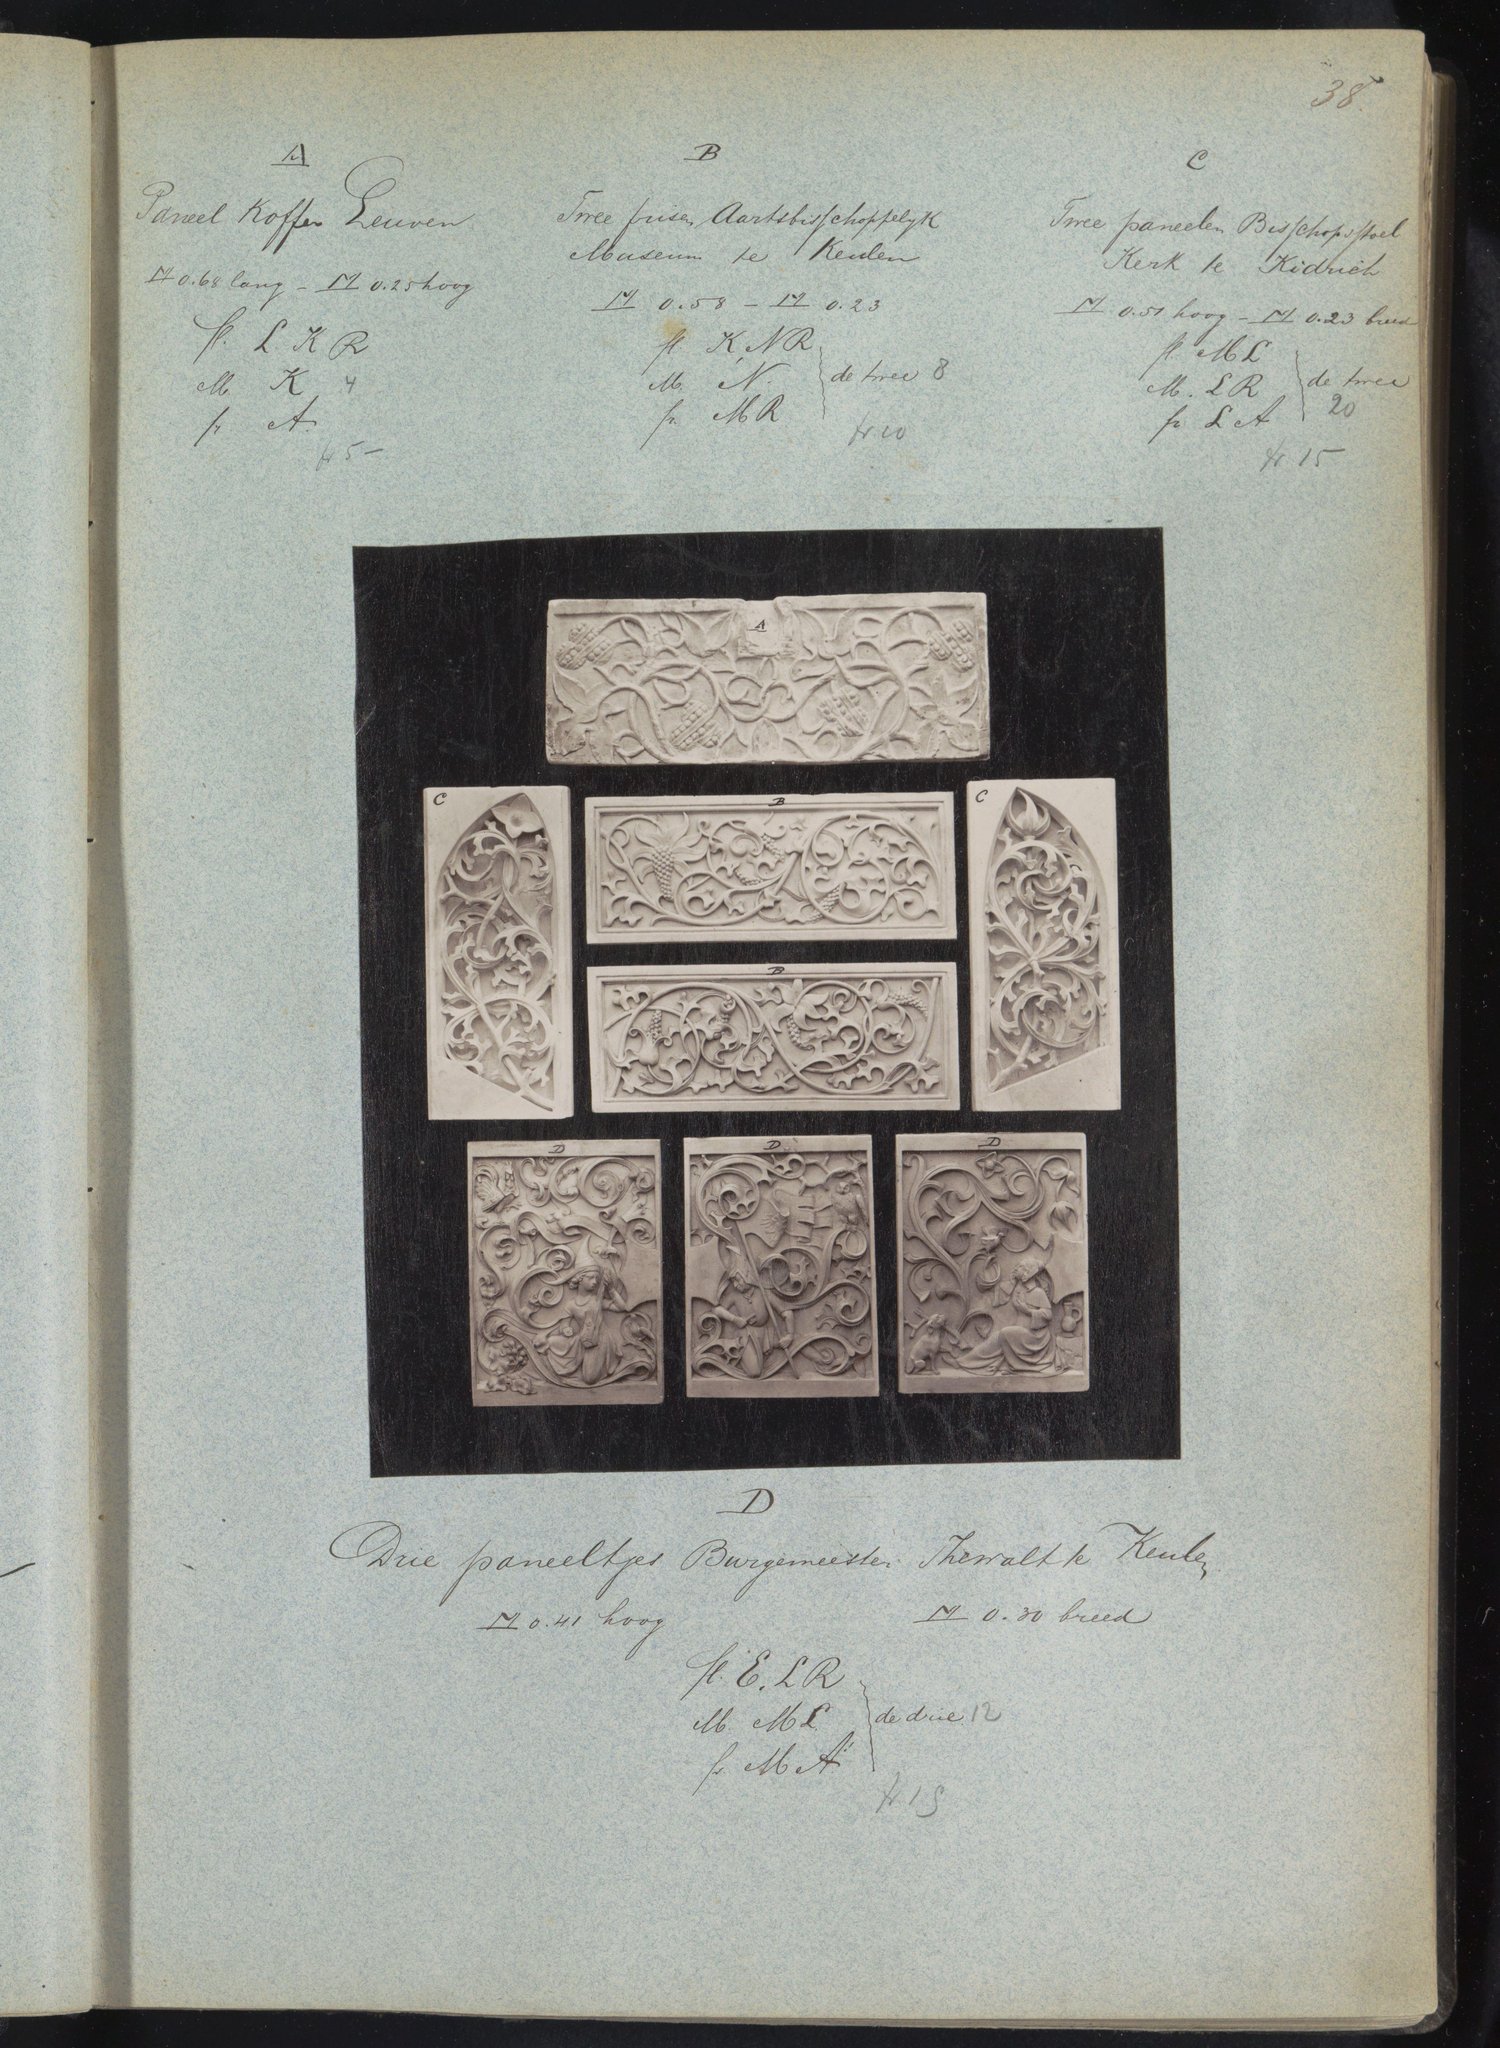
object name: photograph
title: Acht gipsen paneeltjes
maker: Anonymous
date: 1875-1900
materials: paper, photographic support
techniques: albumen print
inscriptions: annotation